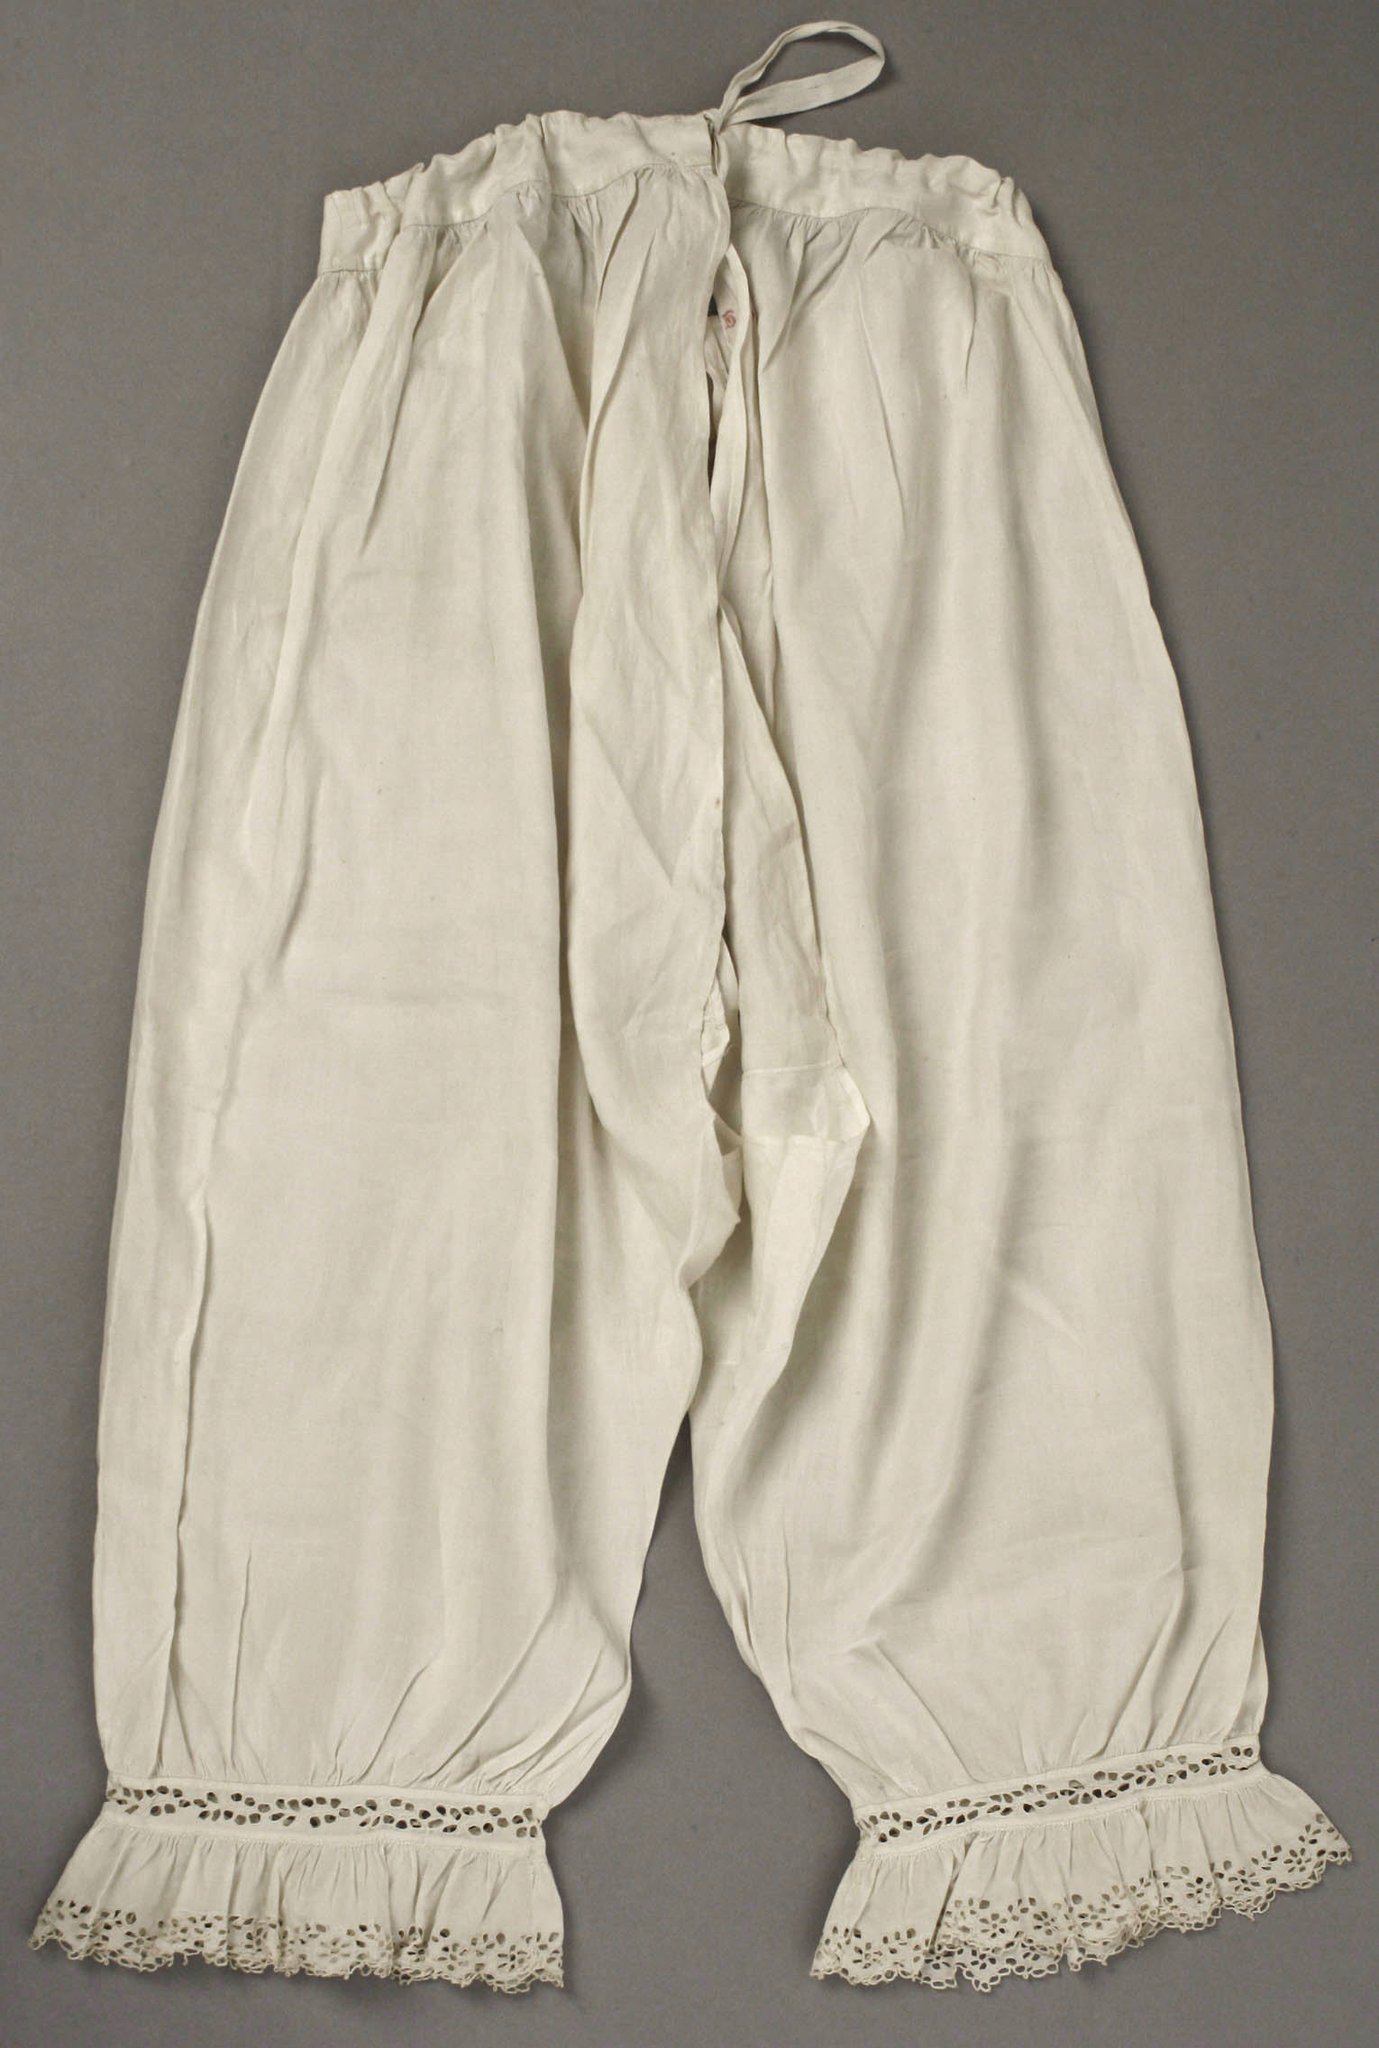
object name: drawer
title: Drawers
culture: american or european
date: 1840-1849